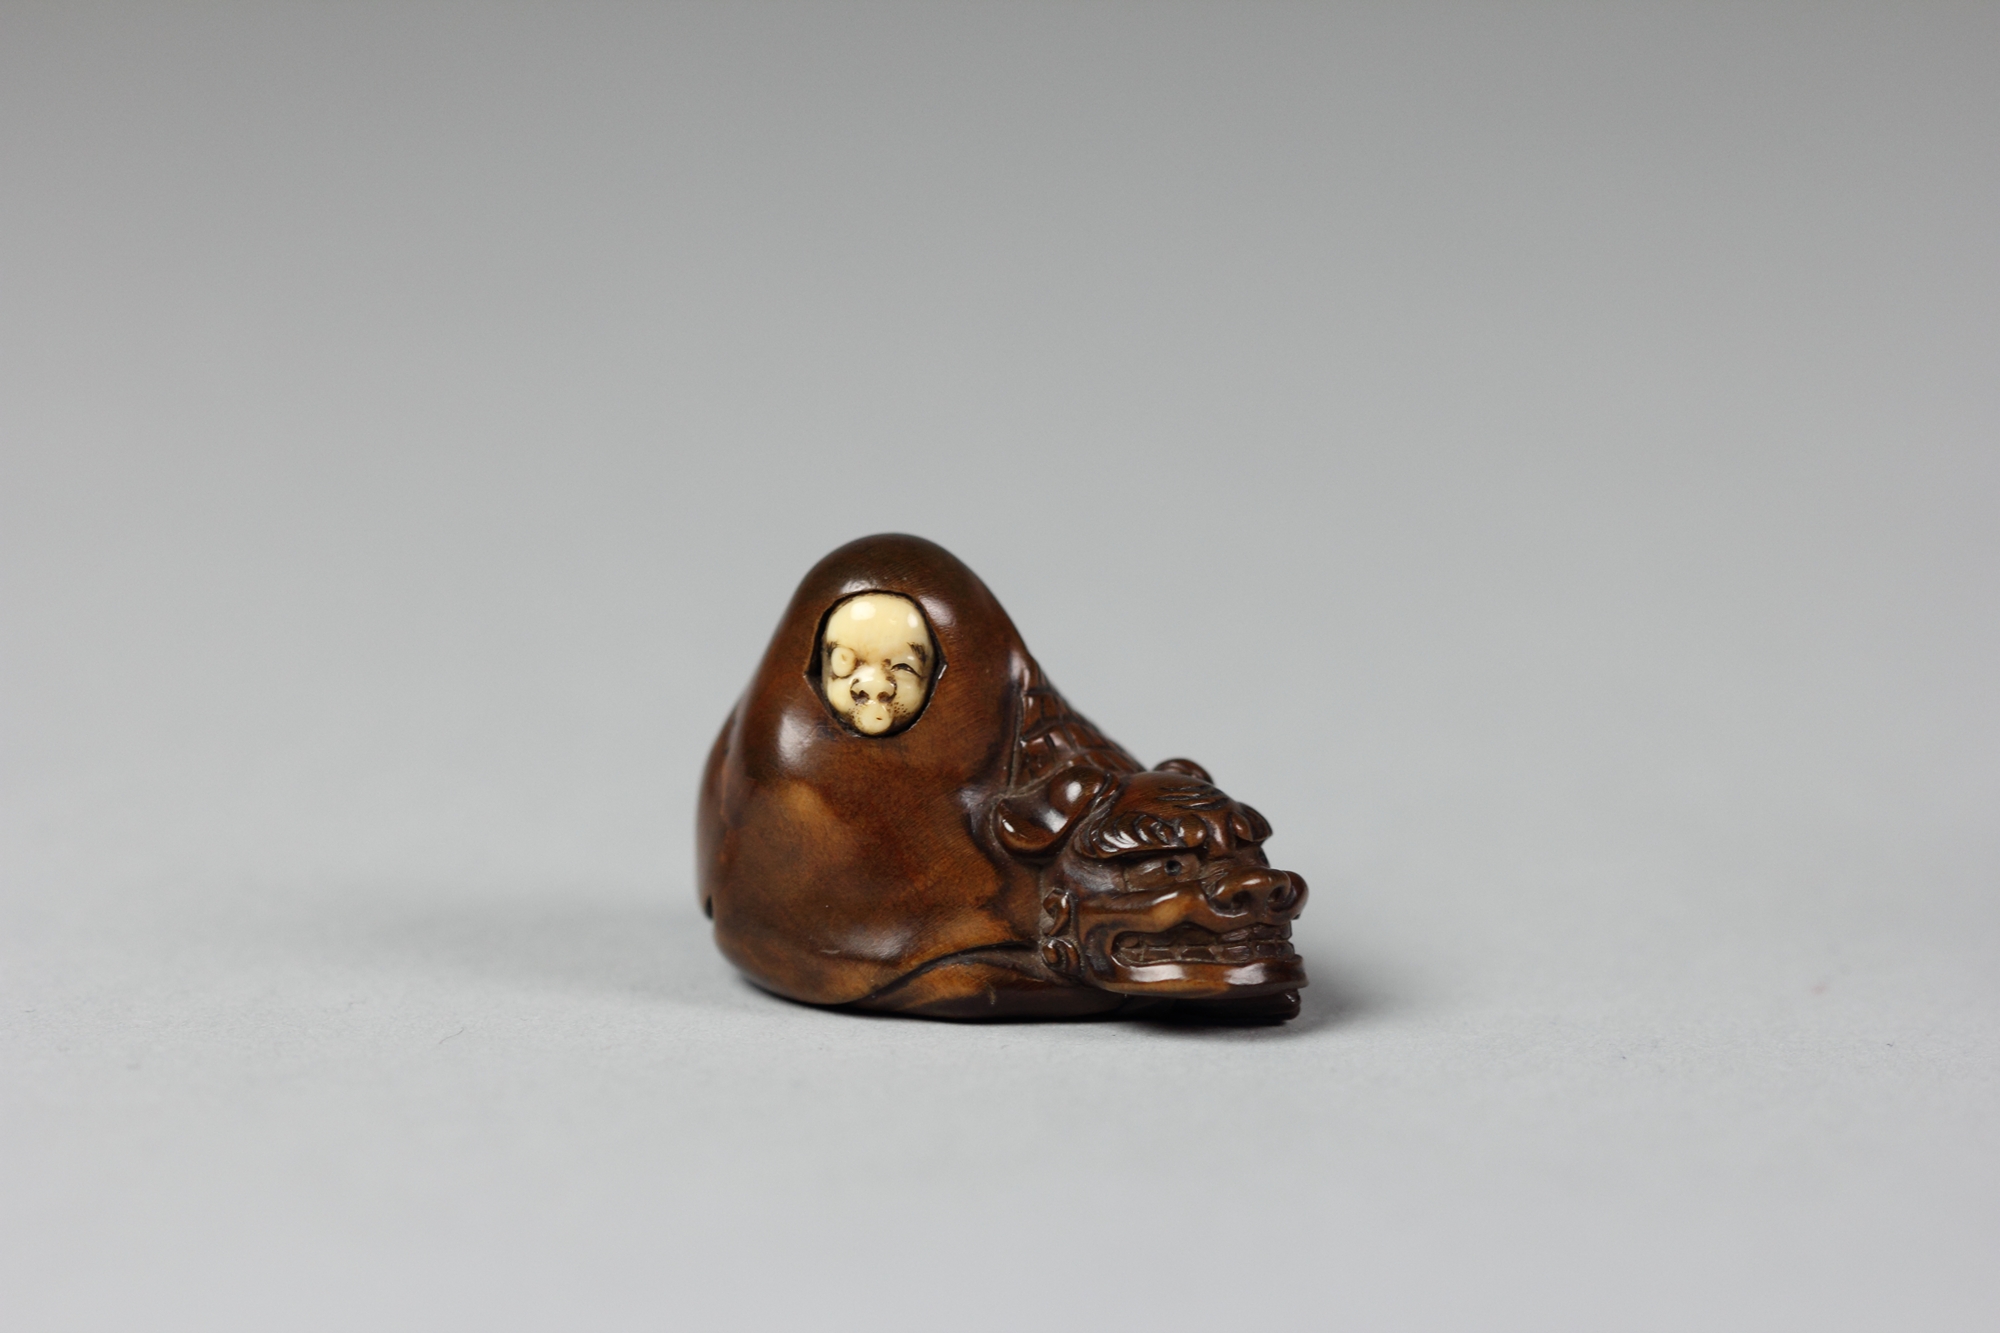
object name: netsuke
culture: japanese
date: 1701-1800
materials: ivory, wood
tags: human figures,animals